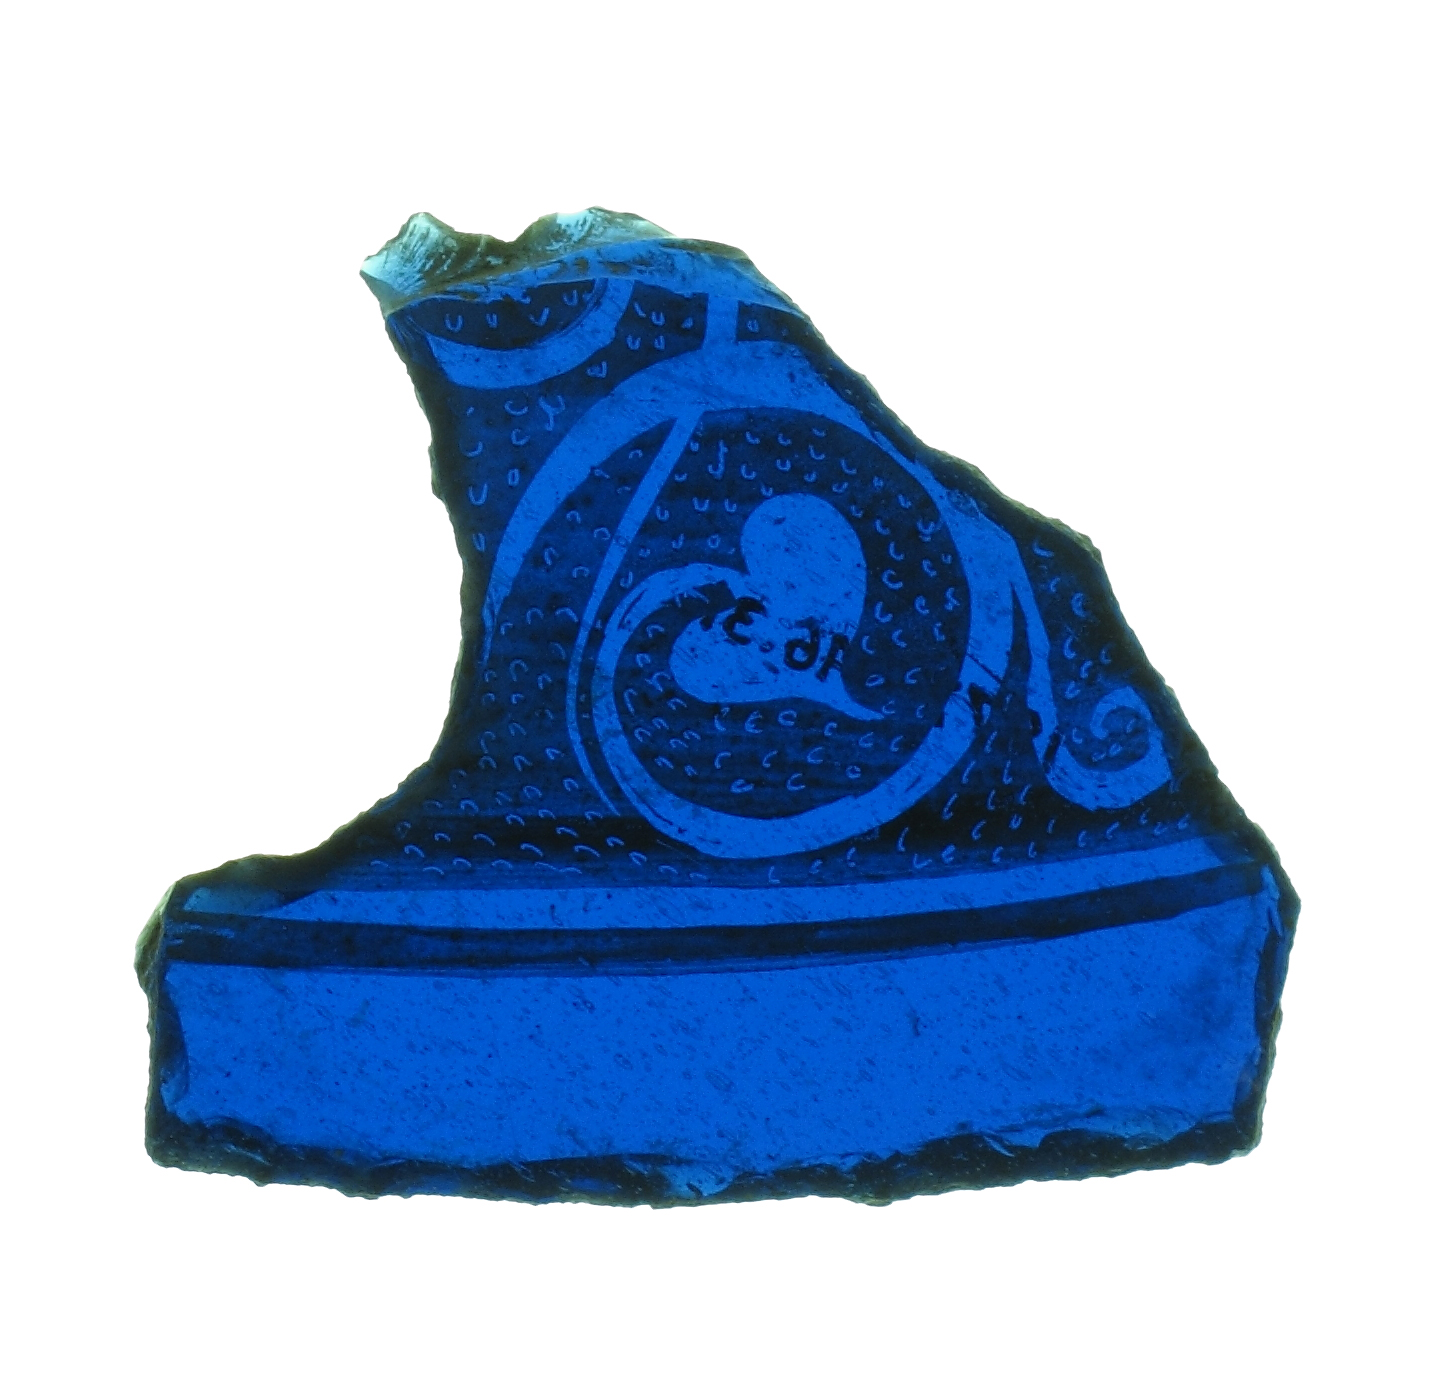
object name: fragment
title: Glass Fragment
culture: french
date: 1101-1400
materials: glass, metal, paint